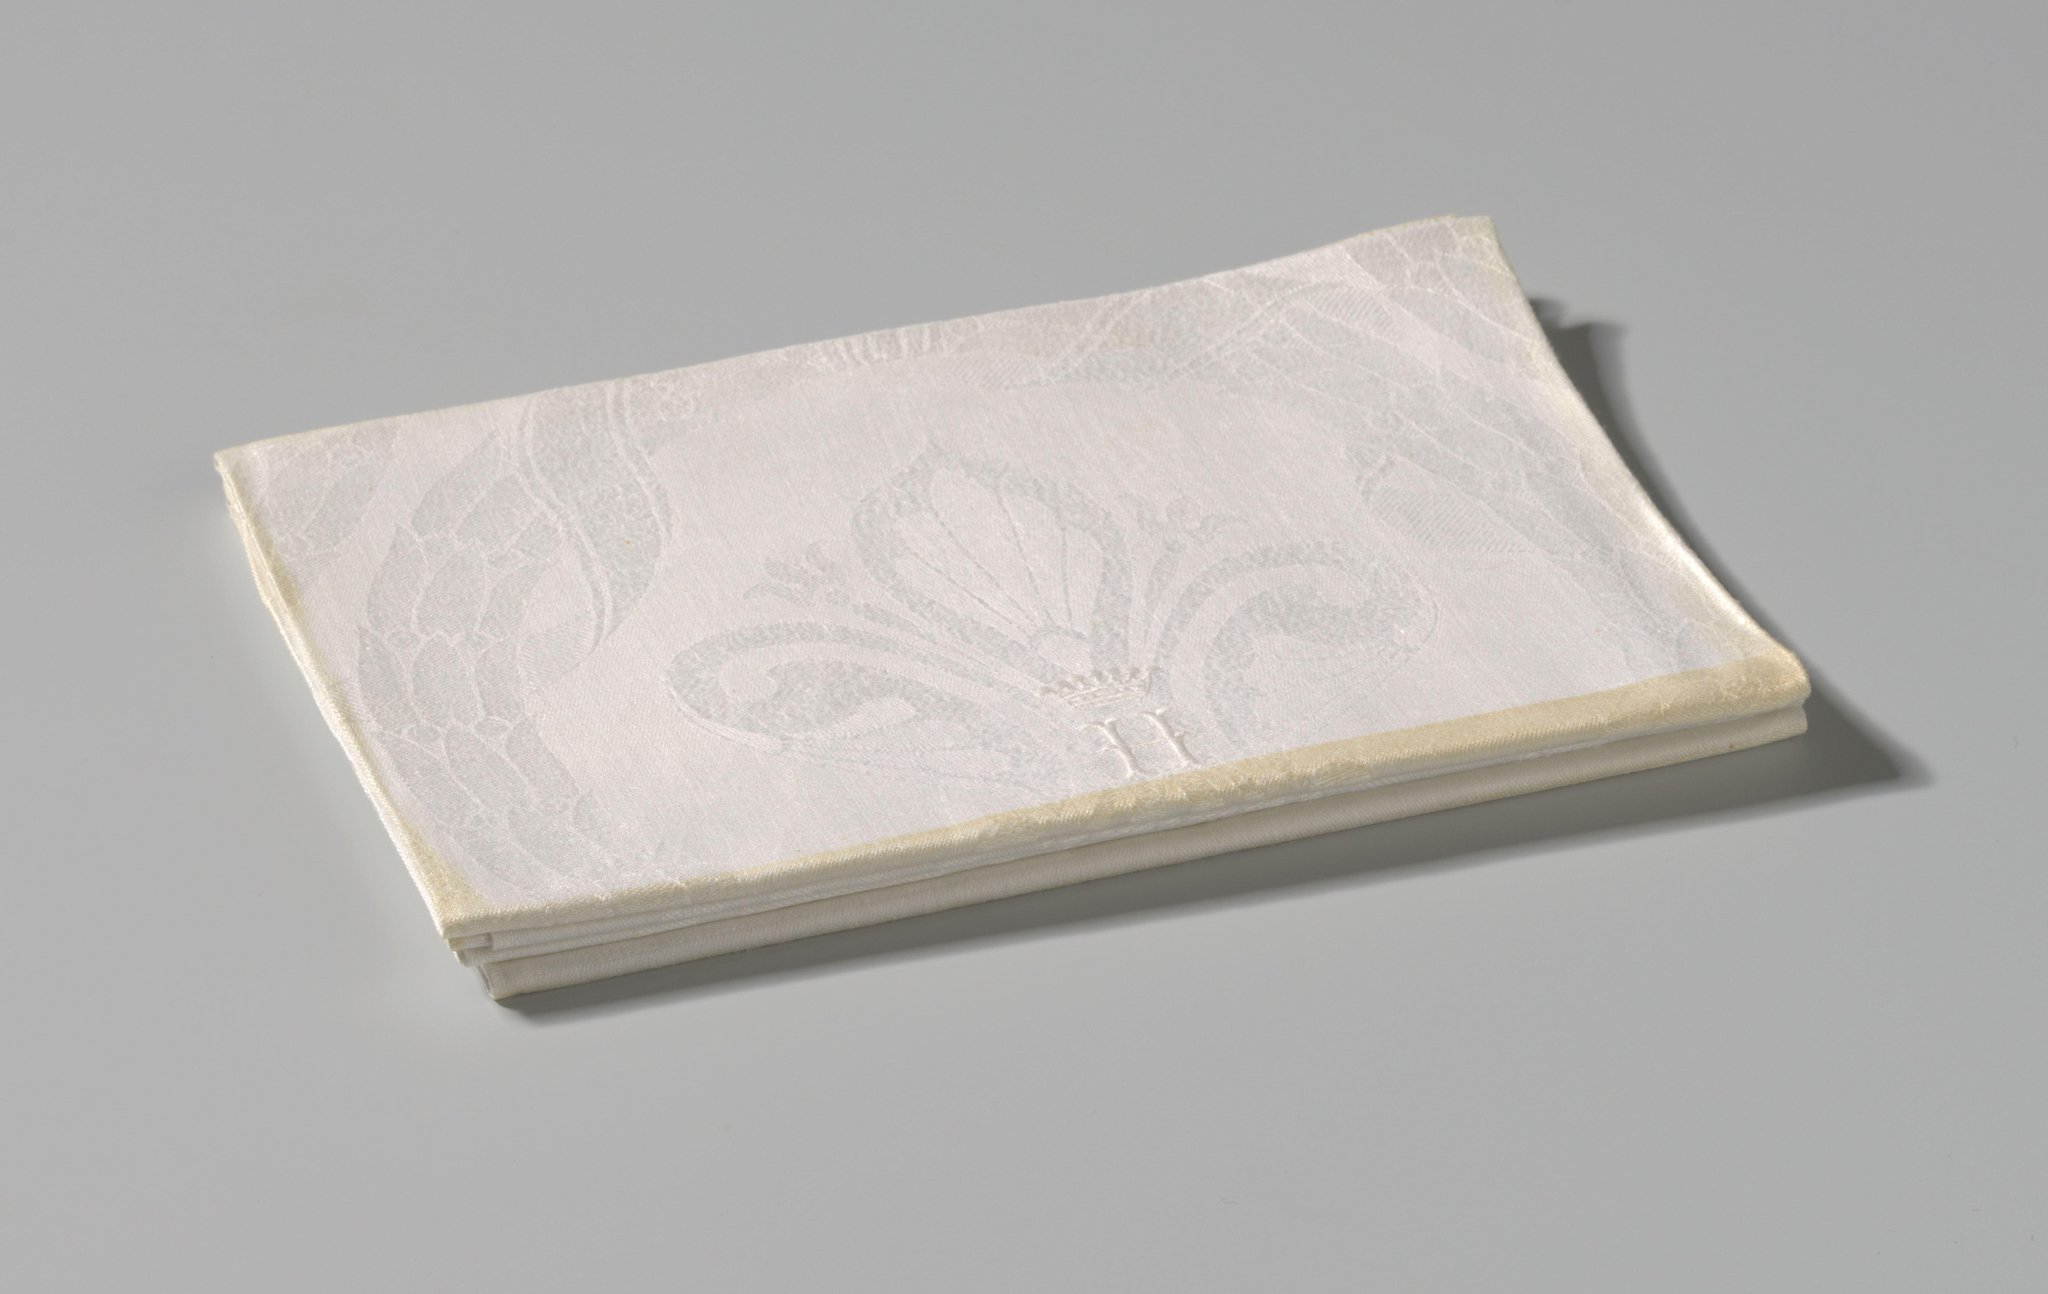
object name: towel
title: Handdoek van wit linnen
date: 1880-1920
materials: linen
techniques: damask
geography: northern netherlands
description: Wit linnen handdoek met een patroon van een strepenrand met lelies, merk kroon H.